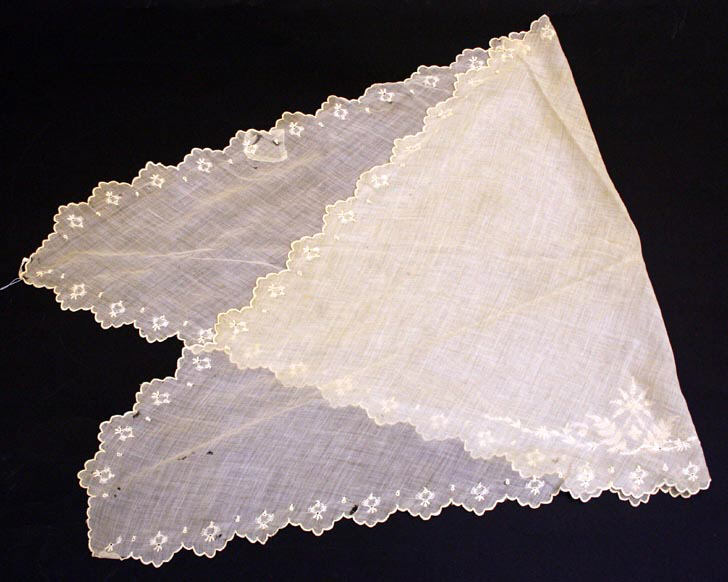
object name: fichu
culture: american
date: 1876